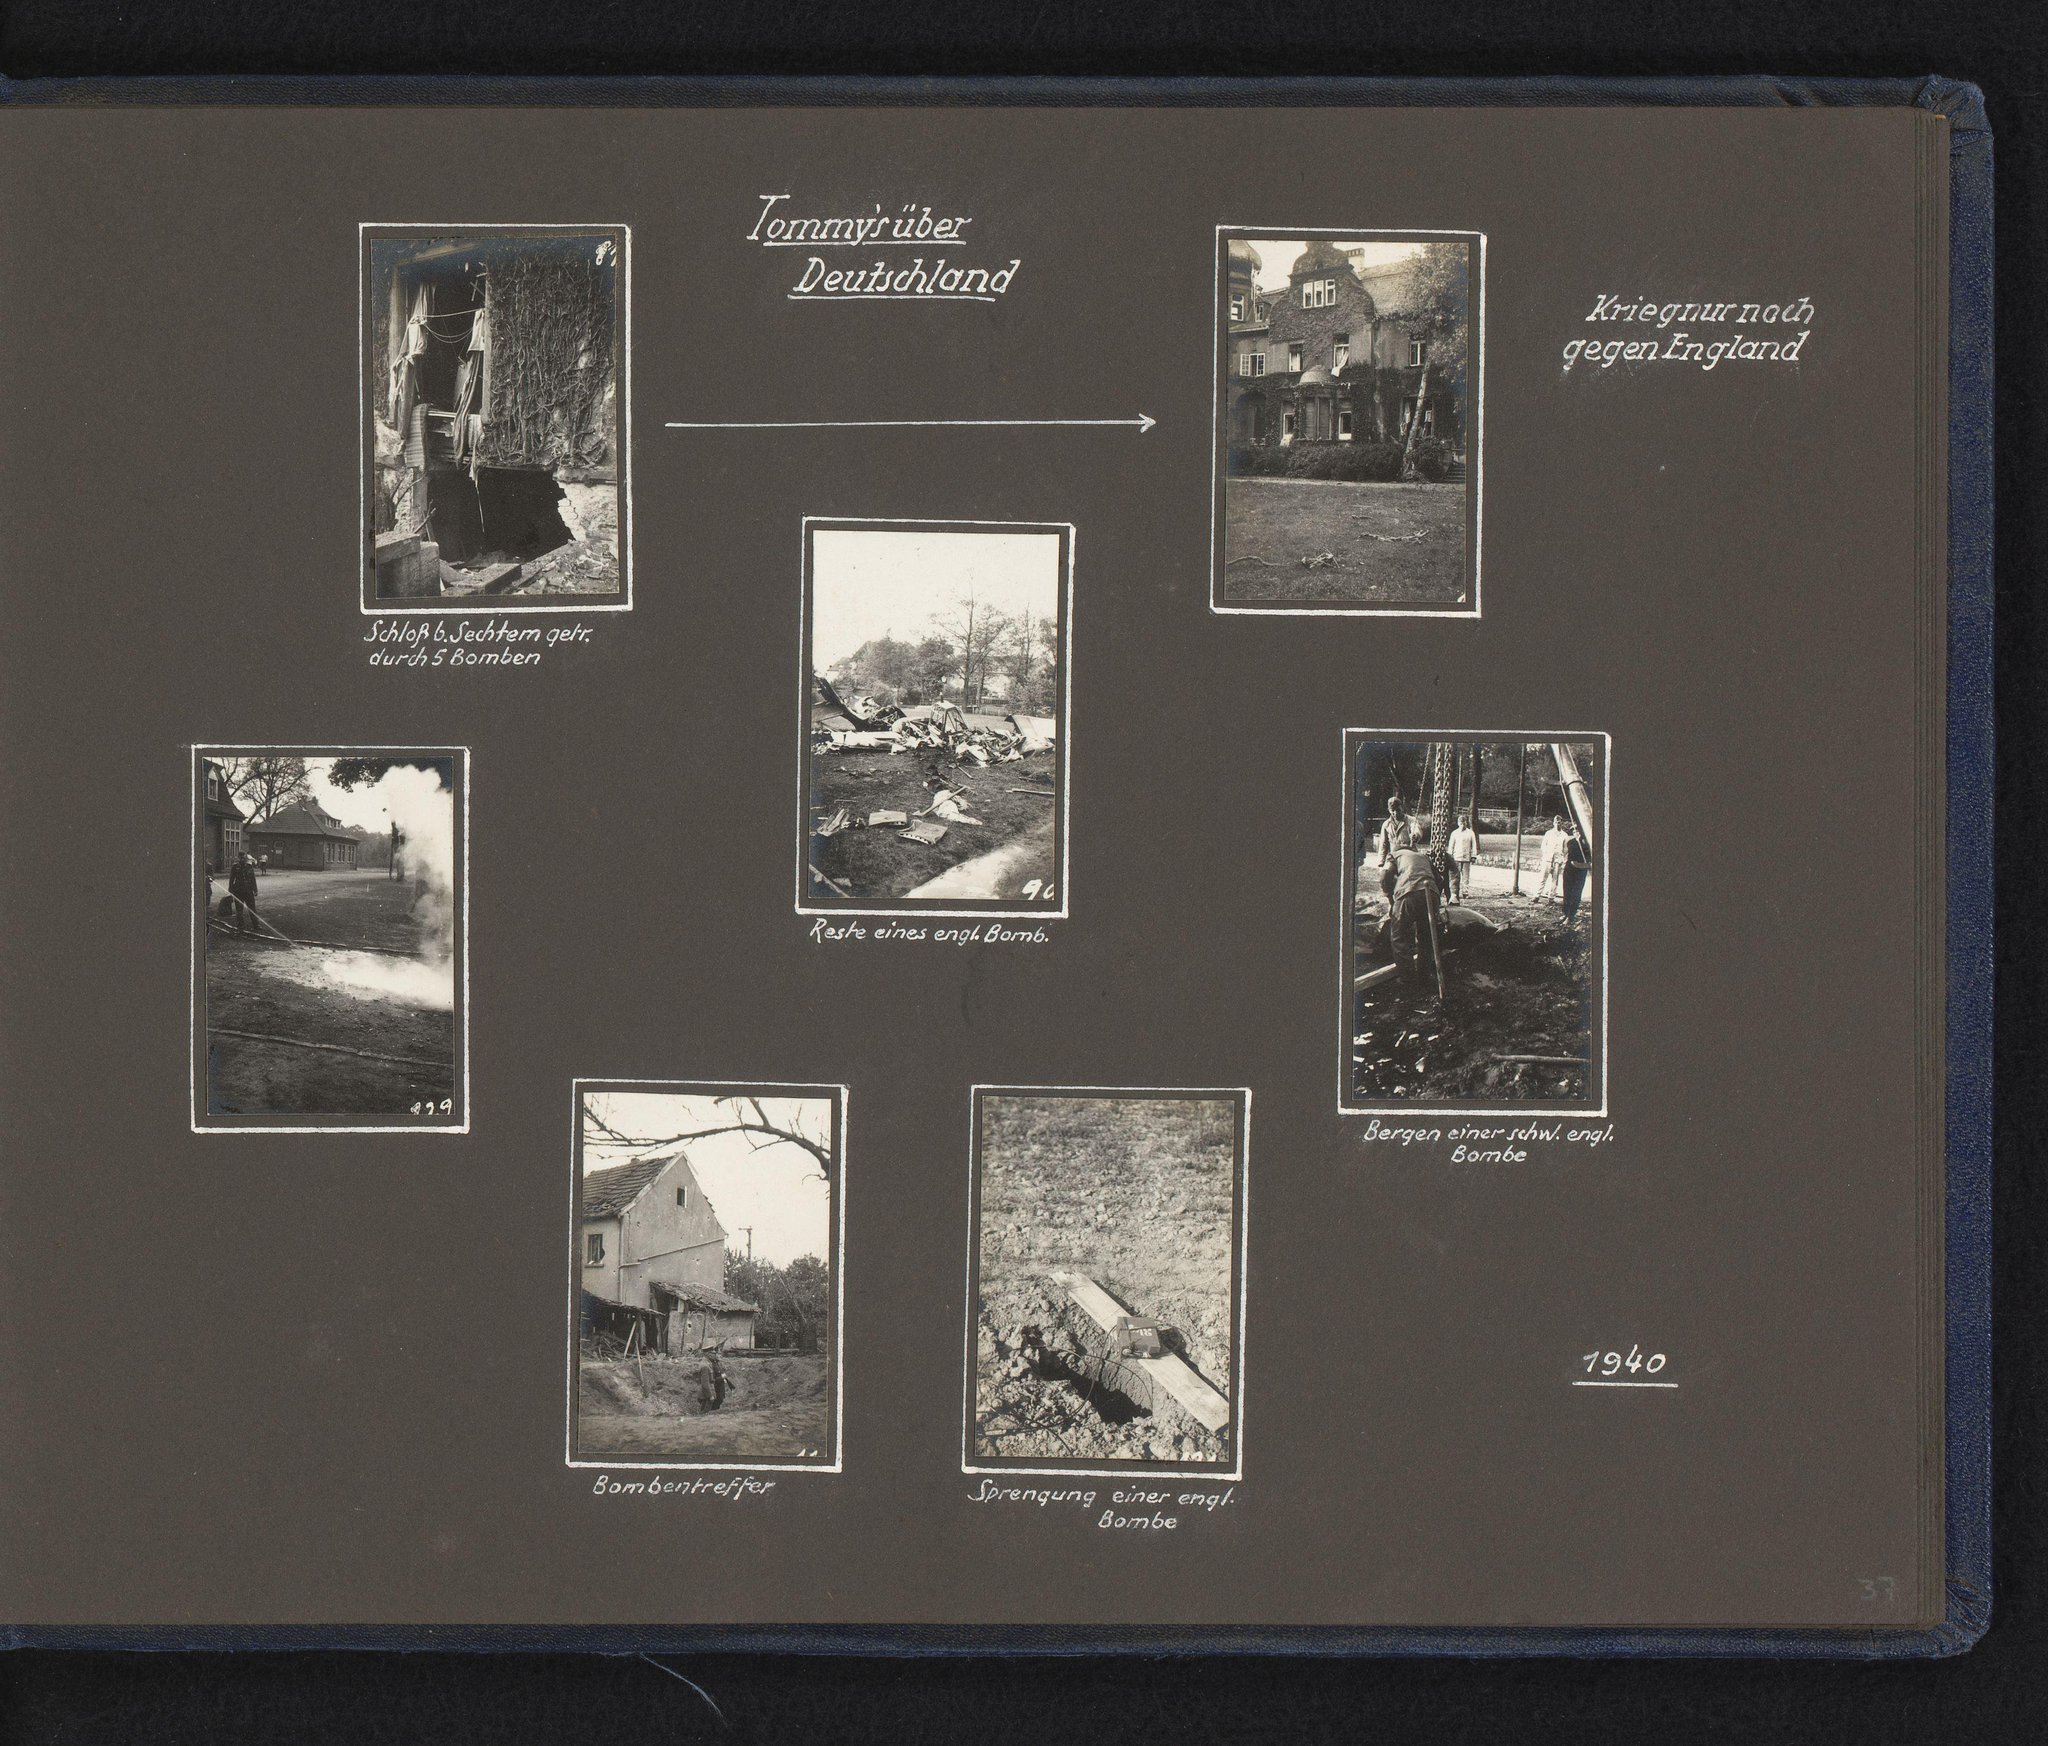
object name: album leaf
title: Engelse bommen in Duitsland, 1940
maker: Anonymous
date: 1940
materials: paper, photographic support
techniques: gelatin silver print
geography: germany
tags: projectiles, explosives, etc. (with name), devastated, ruined place or city (~ warfare), germany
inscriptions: date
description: Albumblad met zeven foto's van schade in Duitsland aangericht door Engelse bombardementen in 1940. Onderdeel van een Duits militair album Tweede Wereldoorlog 1939-1940.